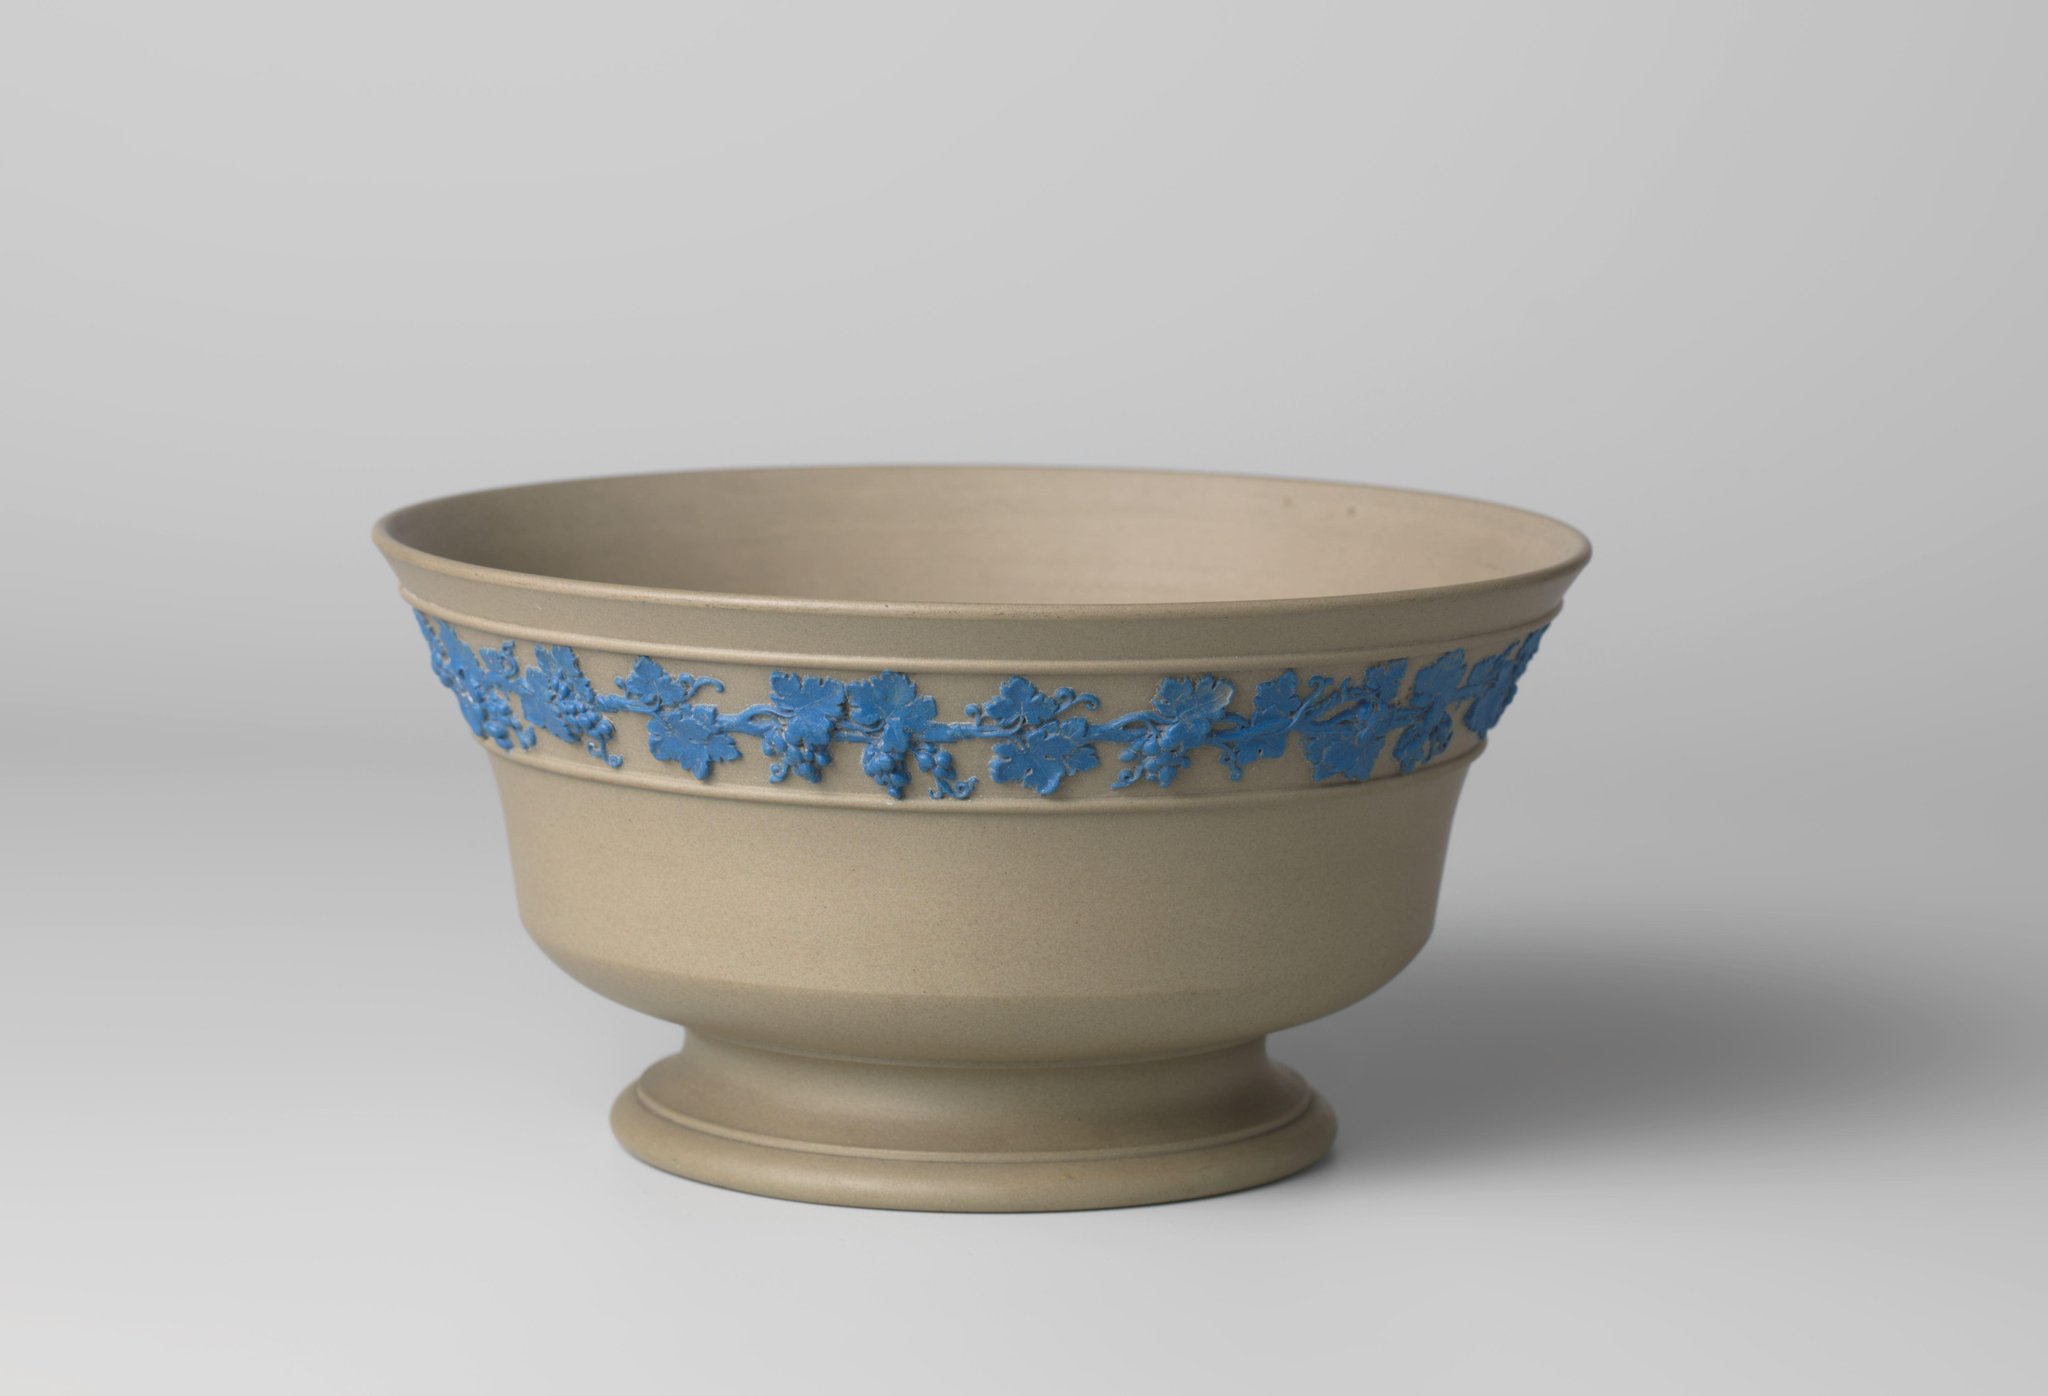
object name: slop bowl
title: Spoelkom van hardgebakken aardewerk; Wedgwood.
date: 1790-1810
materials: earthenware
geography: england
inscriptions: mark: ‘RK’, mark: ‘wedgewood’, mark: ‘RK’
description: Spoelkom van hardgebakken aardewerk. De kom heeft een ingesnoerde trechtervormige buik en staat op een voet. De kom is versierd met een rand druiventrossen en wijnranken in reliëf. Bij de kom hoort een theepot (BK-15430-A), een suikerpot (BK-15430-B) en een melkkan (bk-15430-C). De spoelkom is gemerkt.